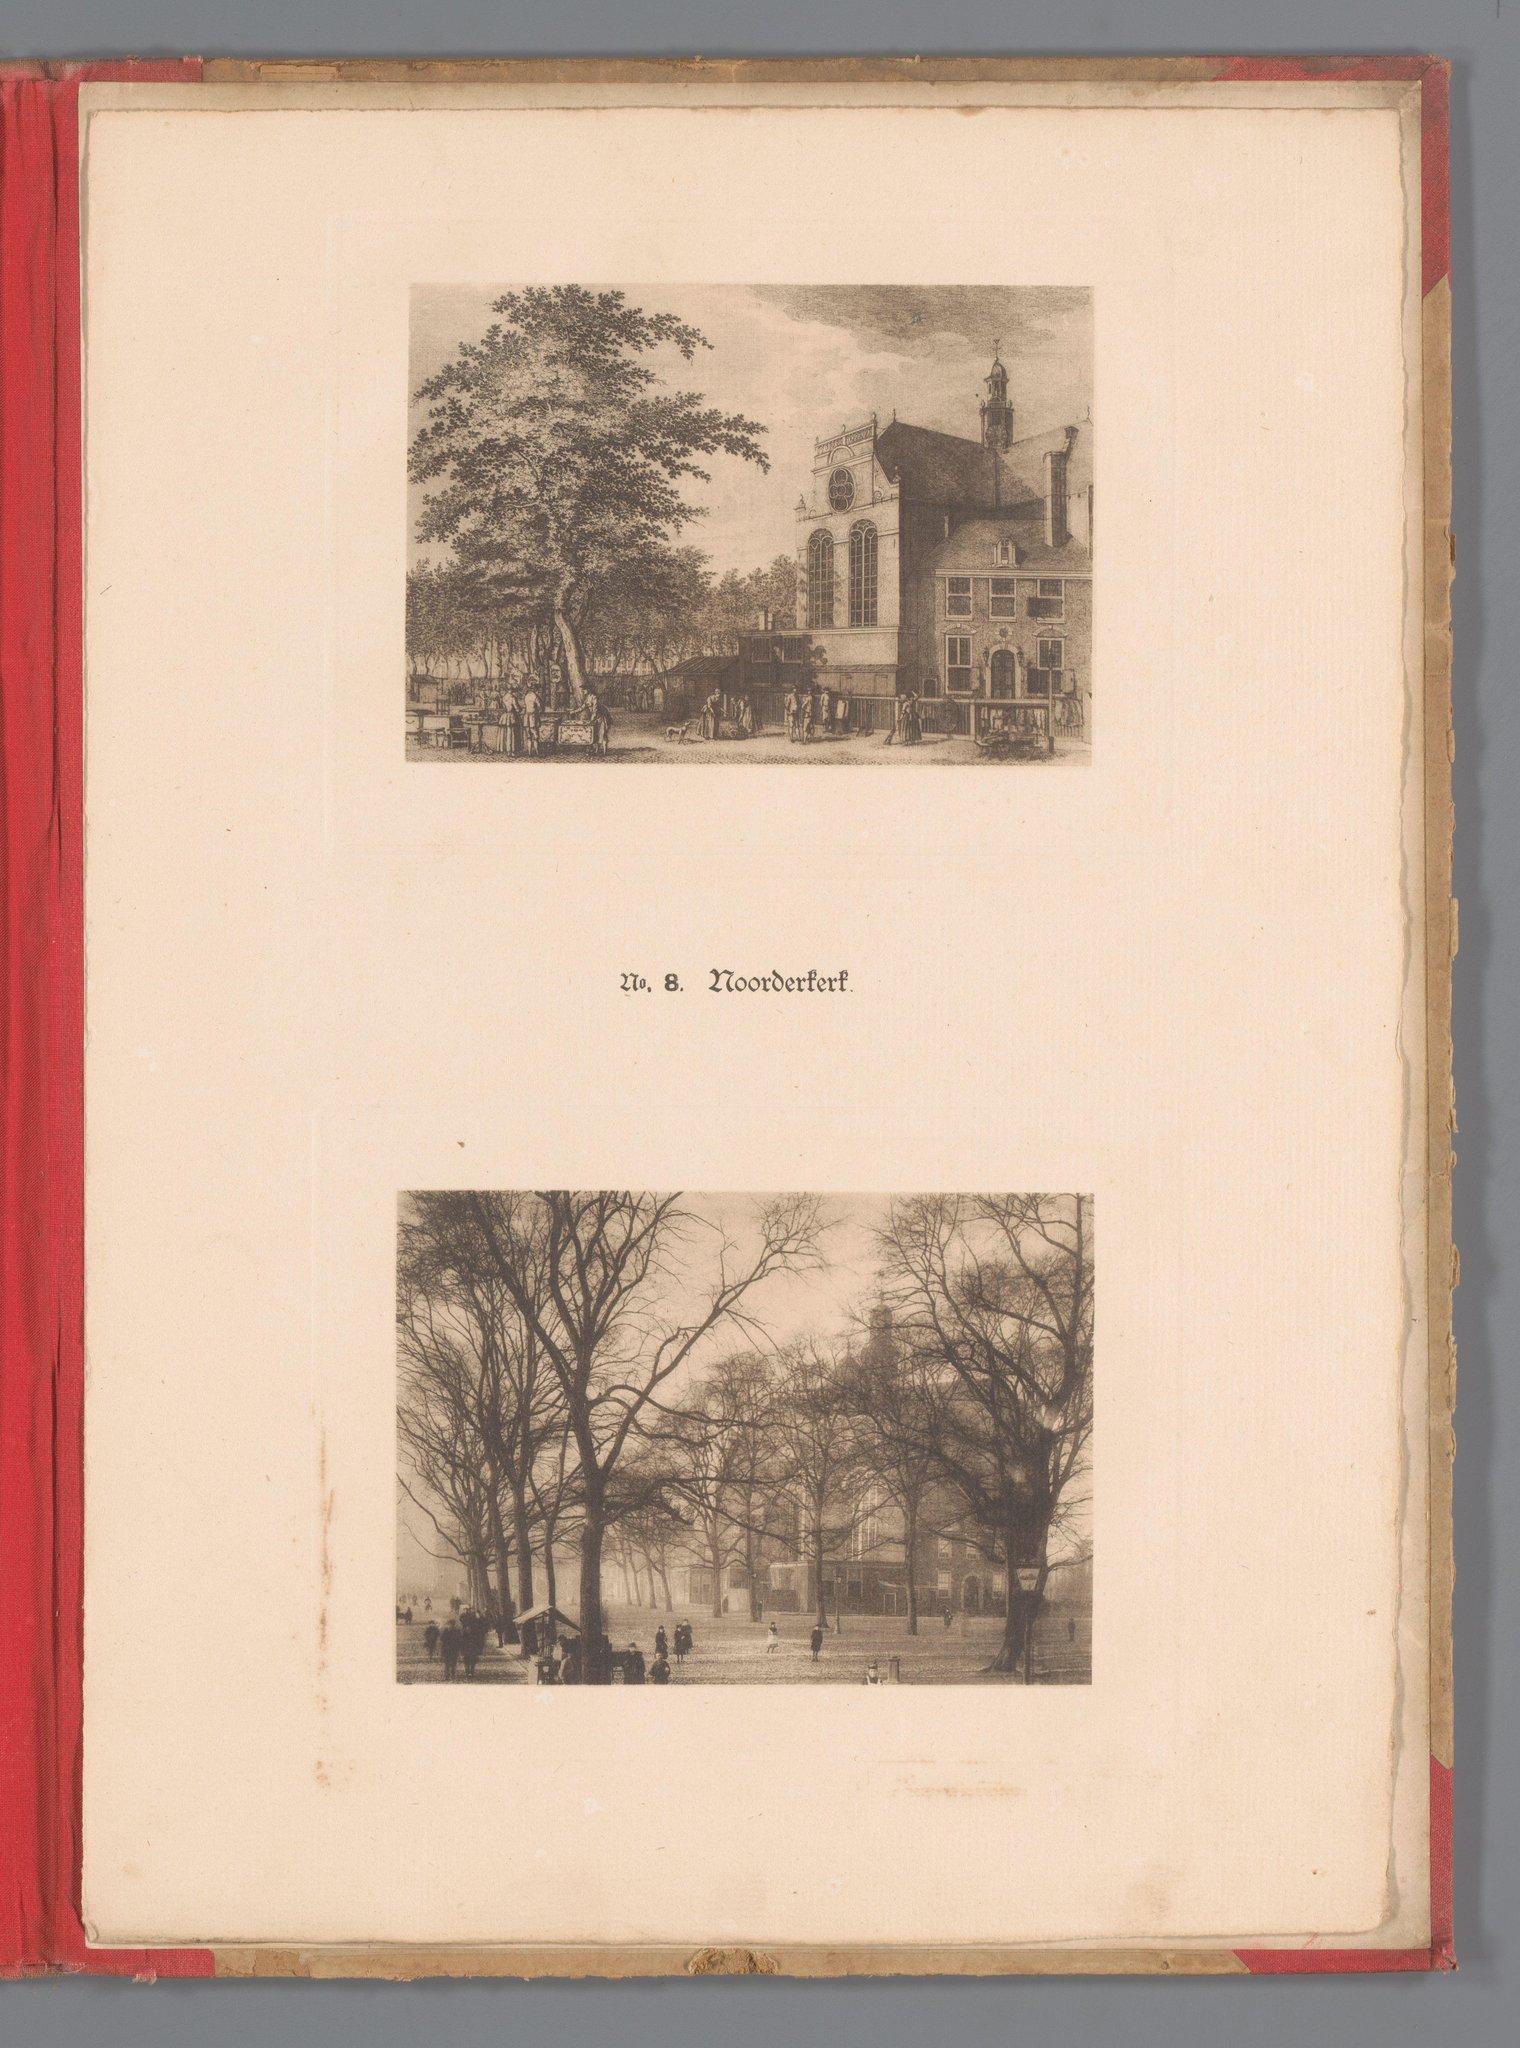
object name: photomechanical print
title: Twee gezichten op de Noorderkerk Amsterdam, waarvan één reproductie van een prent door Hermanus Petrus Schouten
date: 1890-1900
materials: paper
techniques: photograph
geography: amsterdam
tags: church (exterior), street (+ city(-scape) with figures, staffage)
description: Deze prenten maken deel uit van een album.